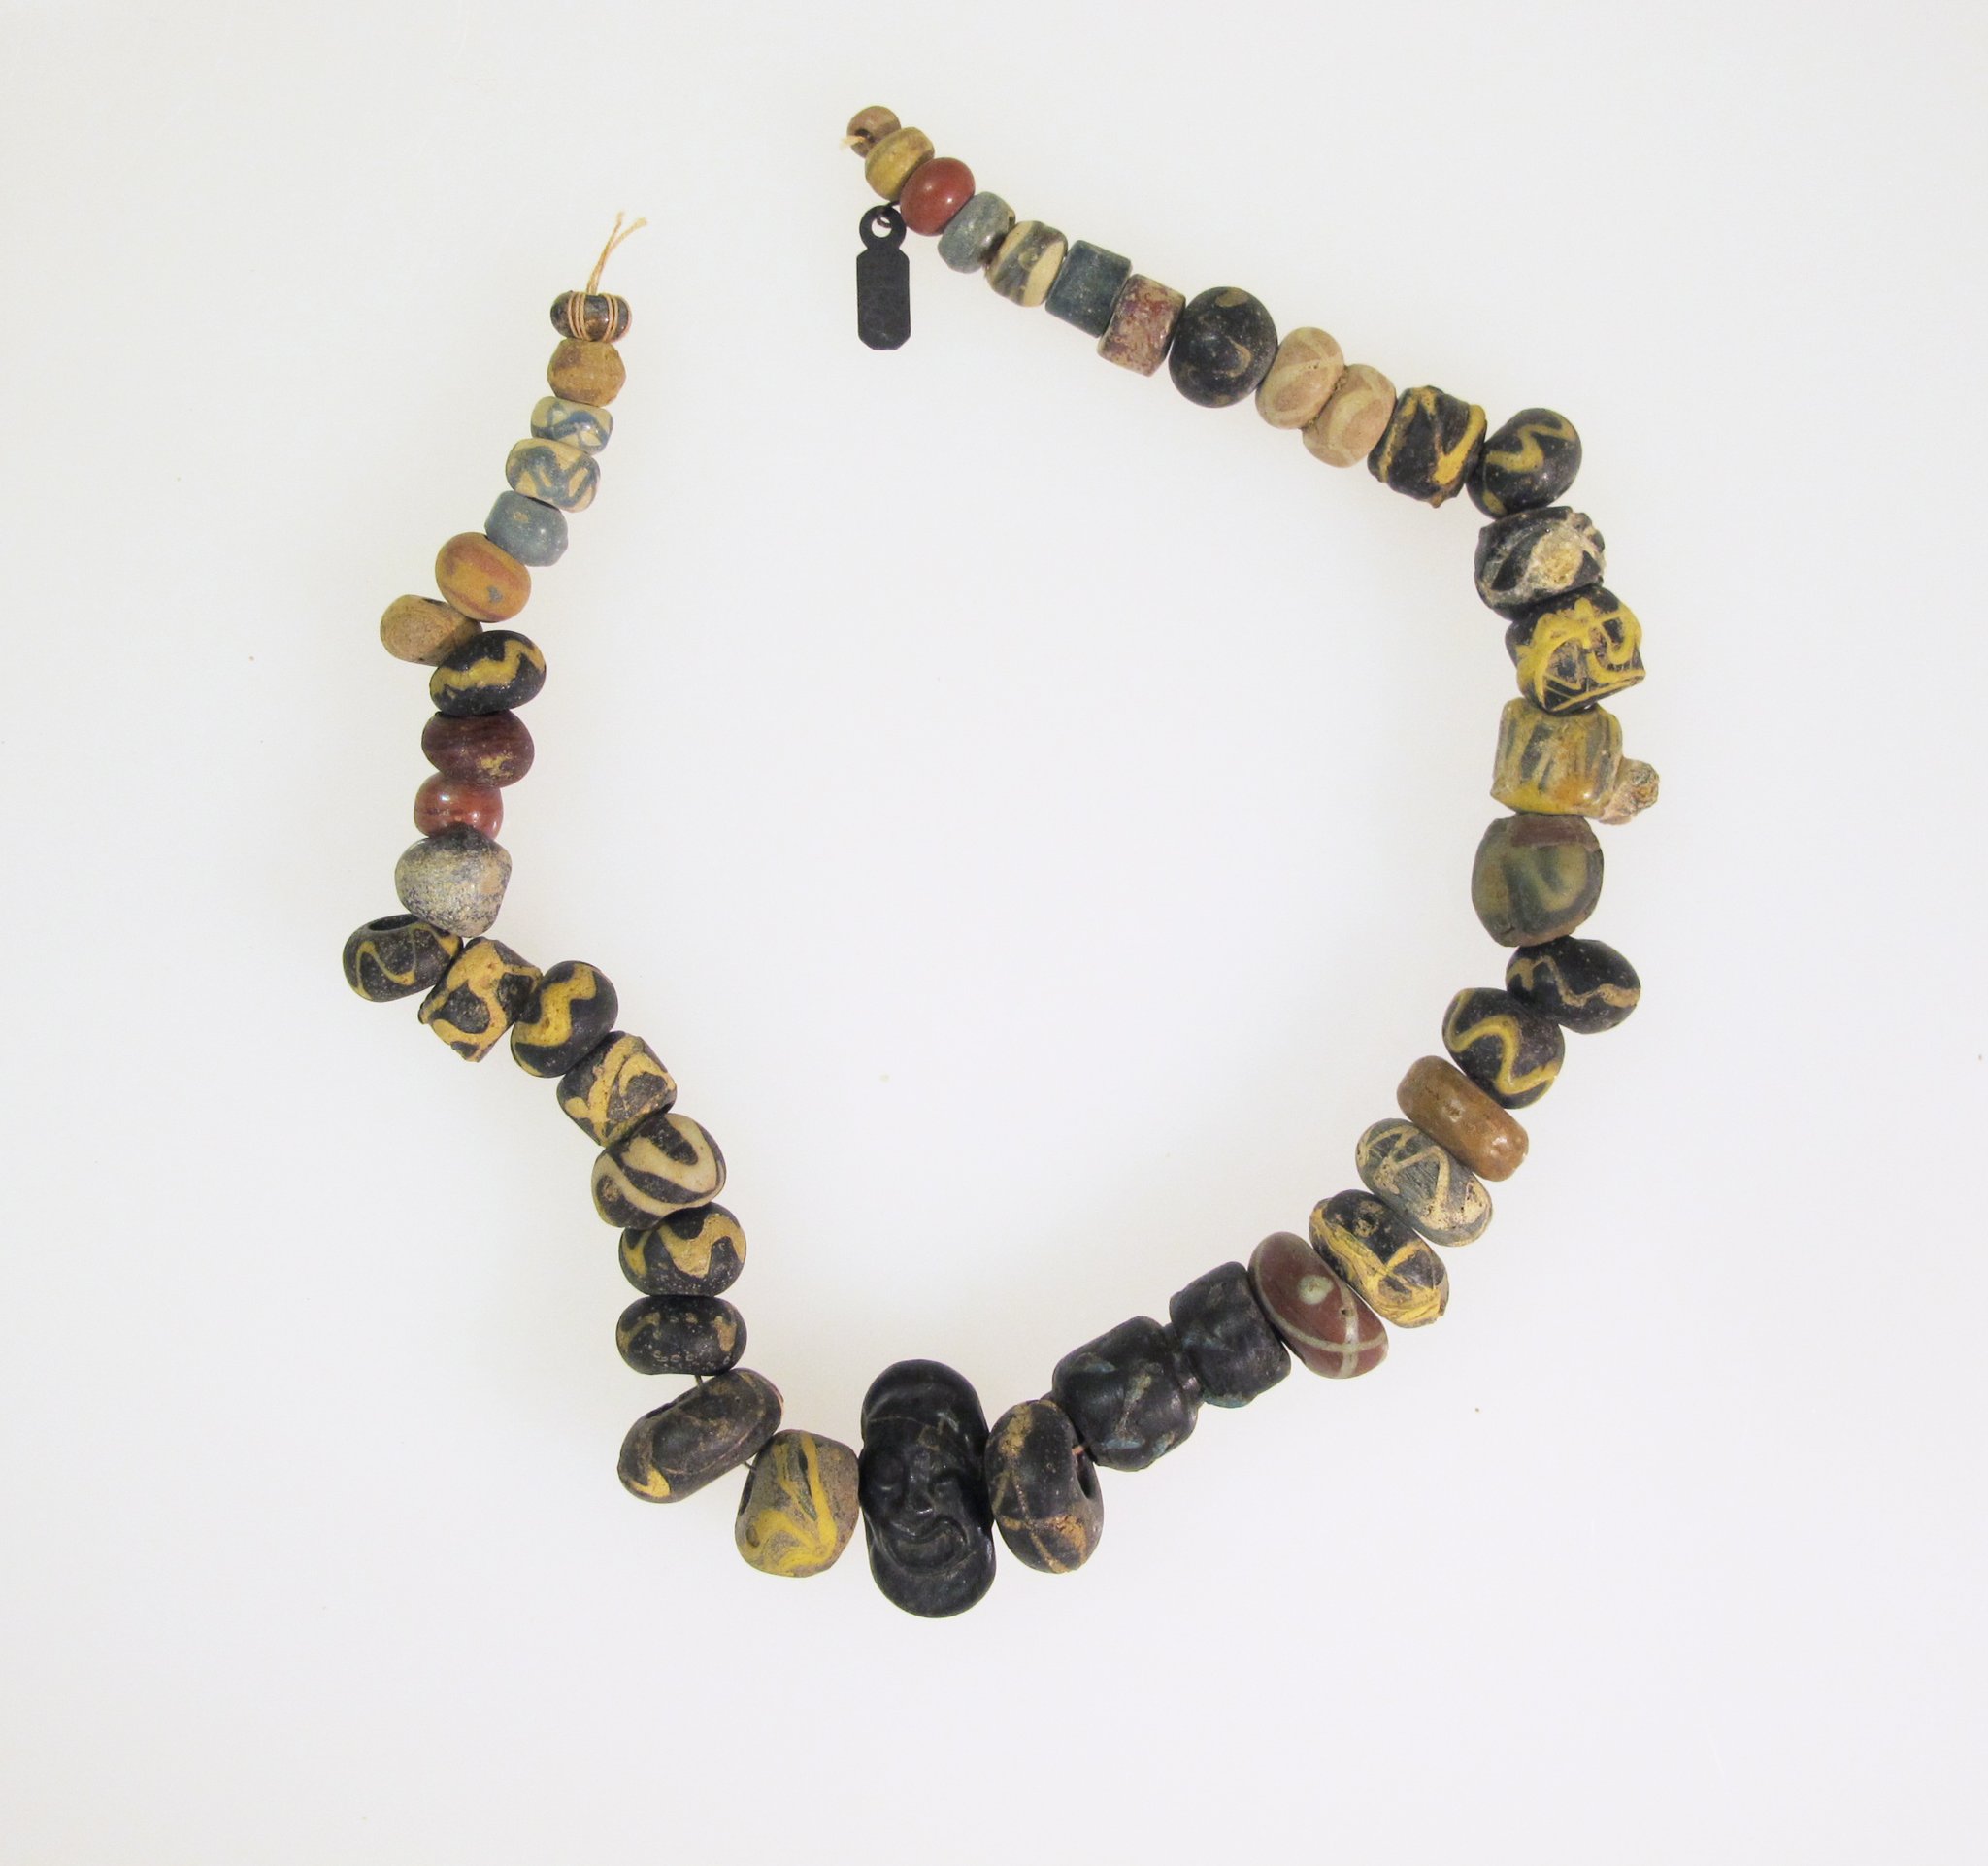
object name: bead, 44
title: Beads, 44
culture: roman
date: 670 BCE-330 CE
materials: glass